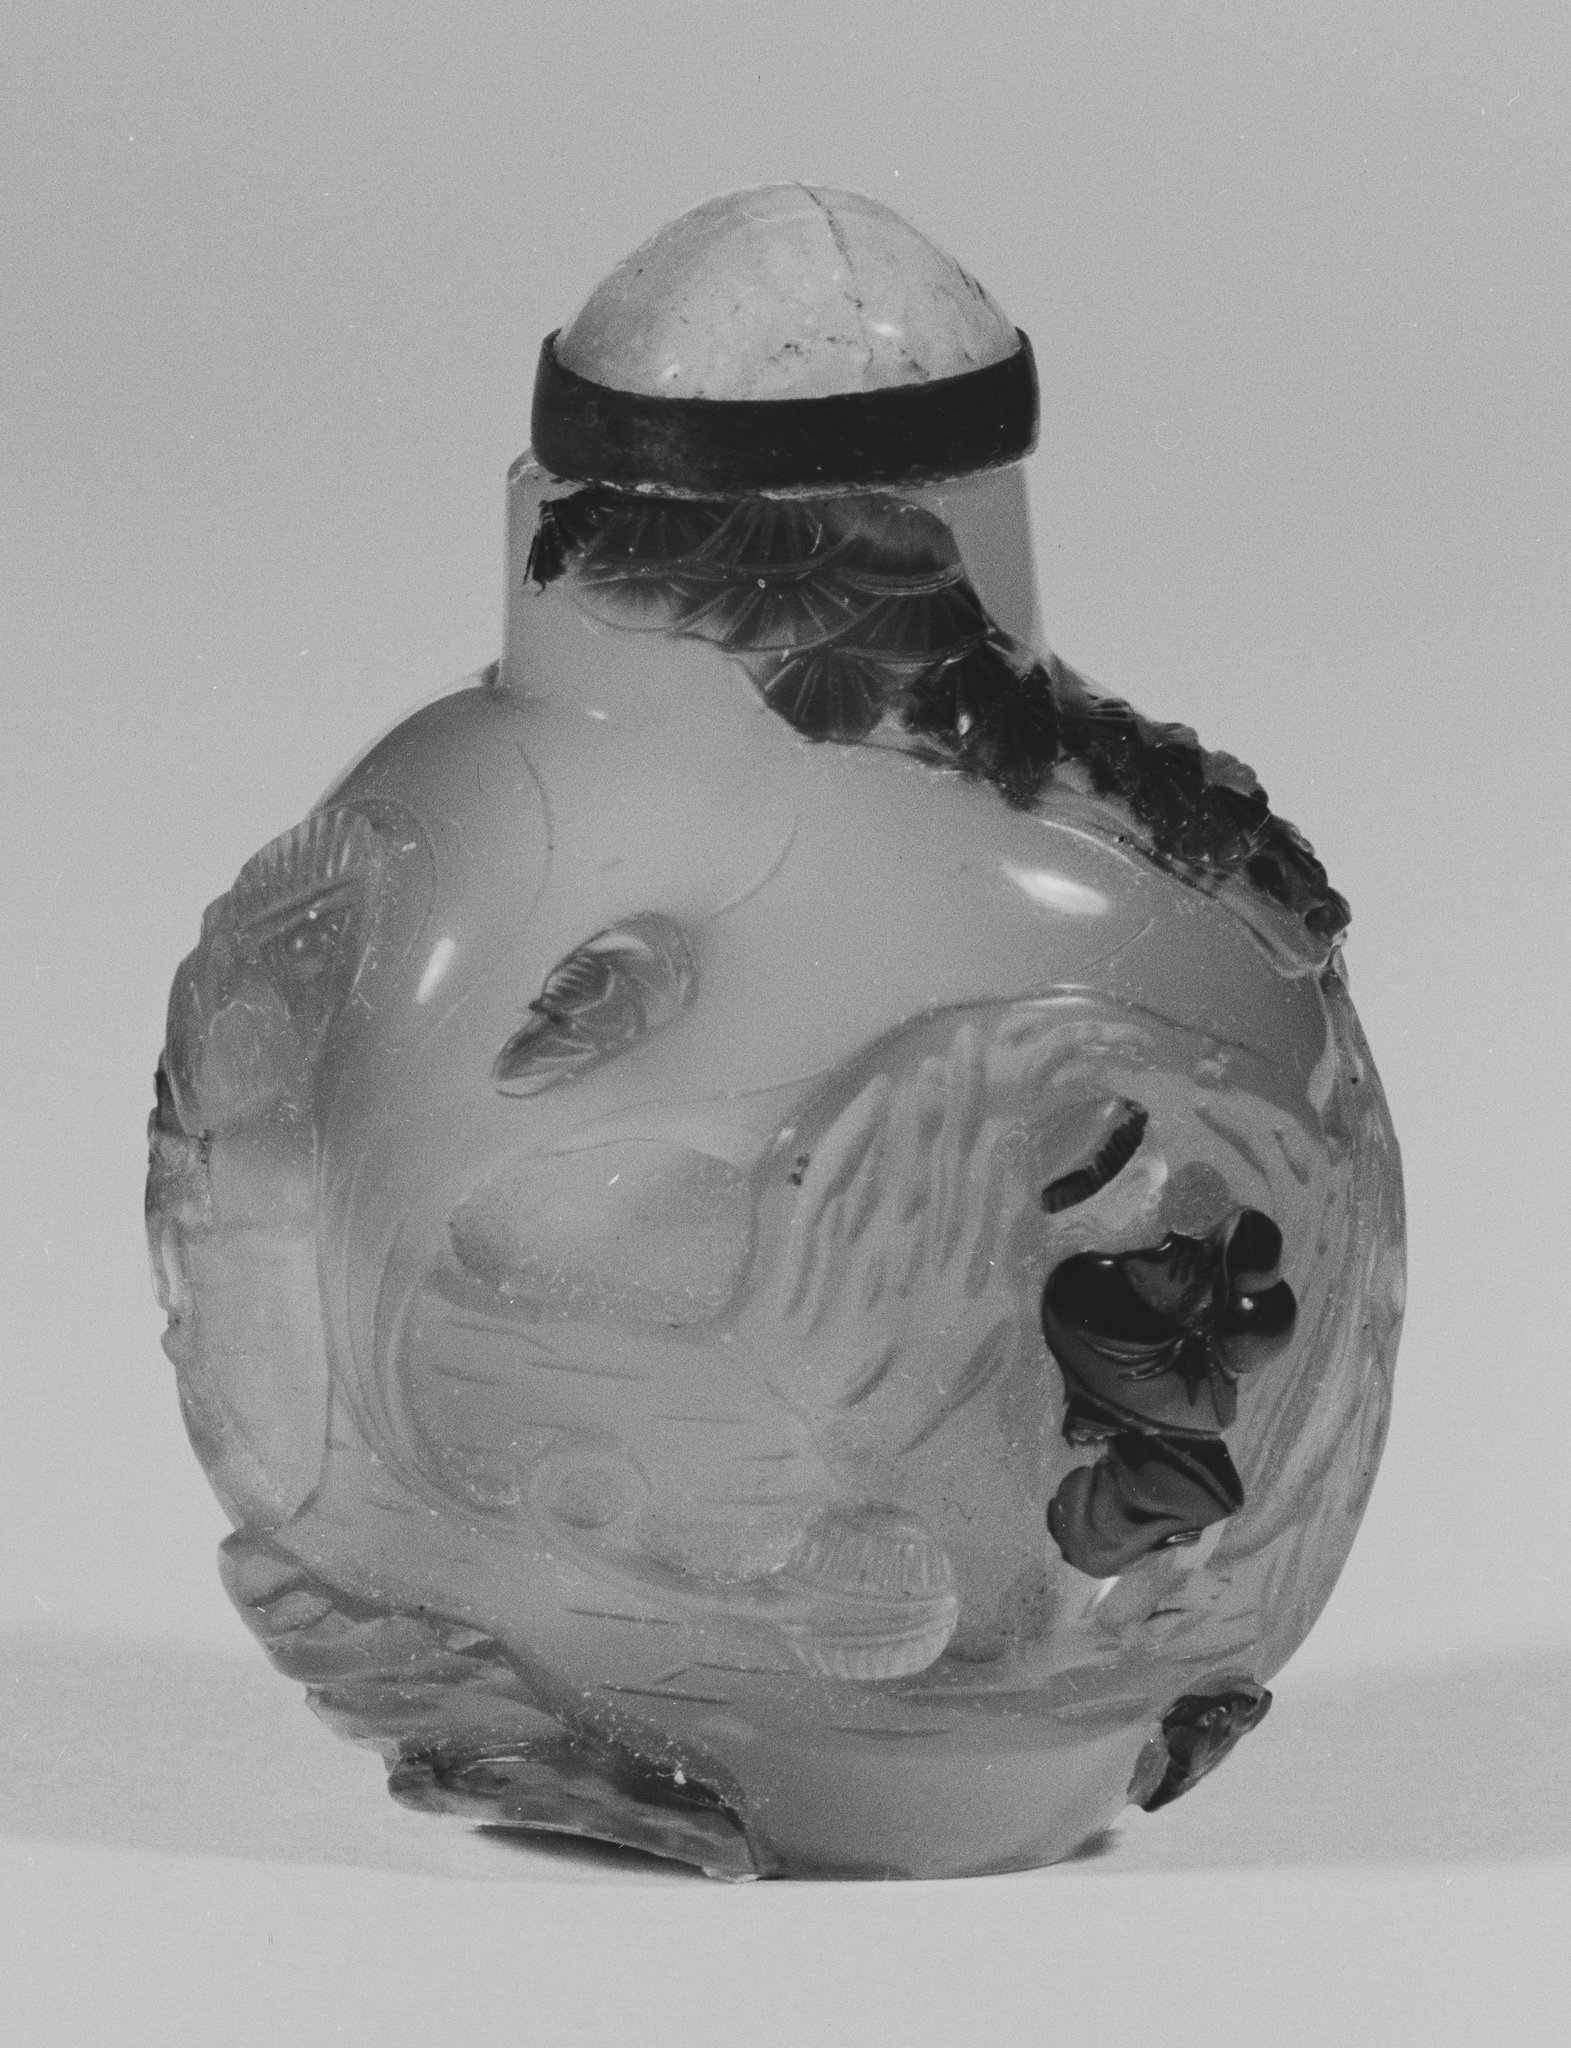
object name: snuff bottle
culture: chinese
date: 1851-1900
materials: stone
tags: human figures